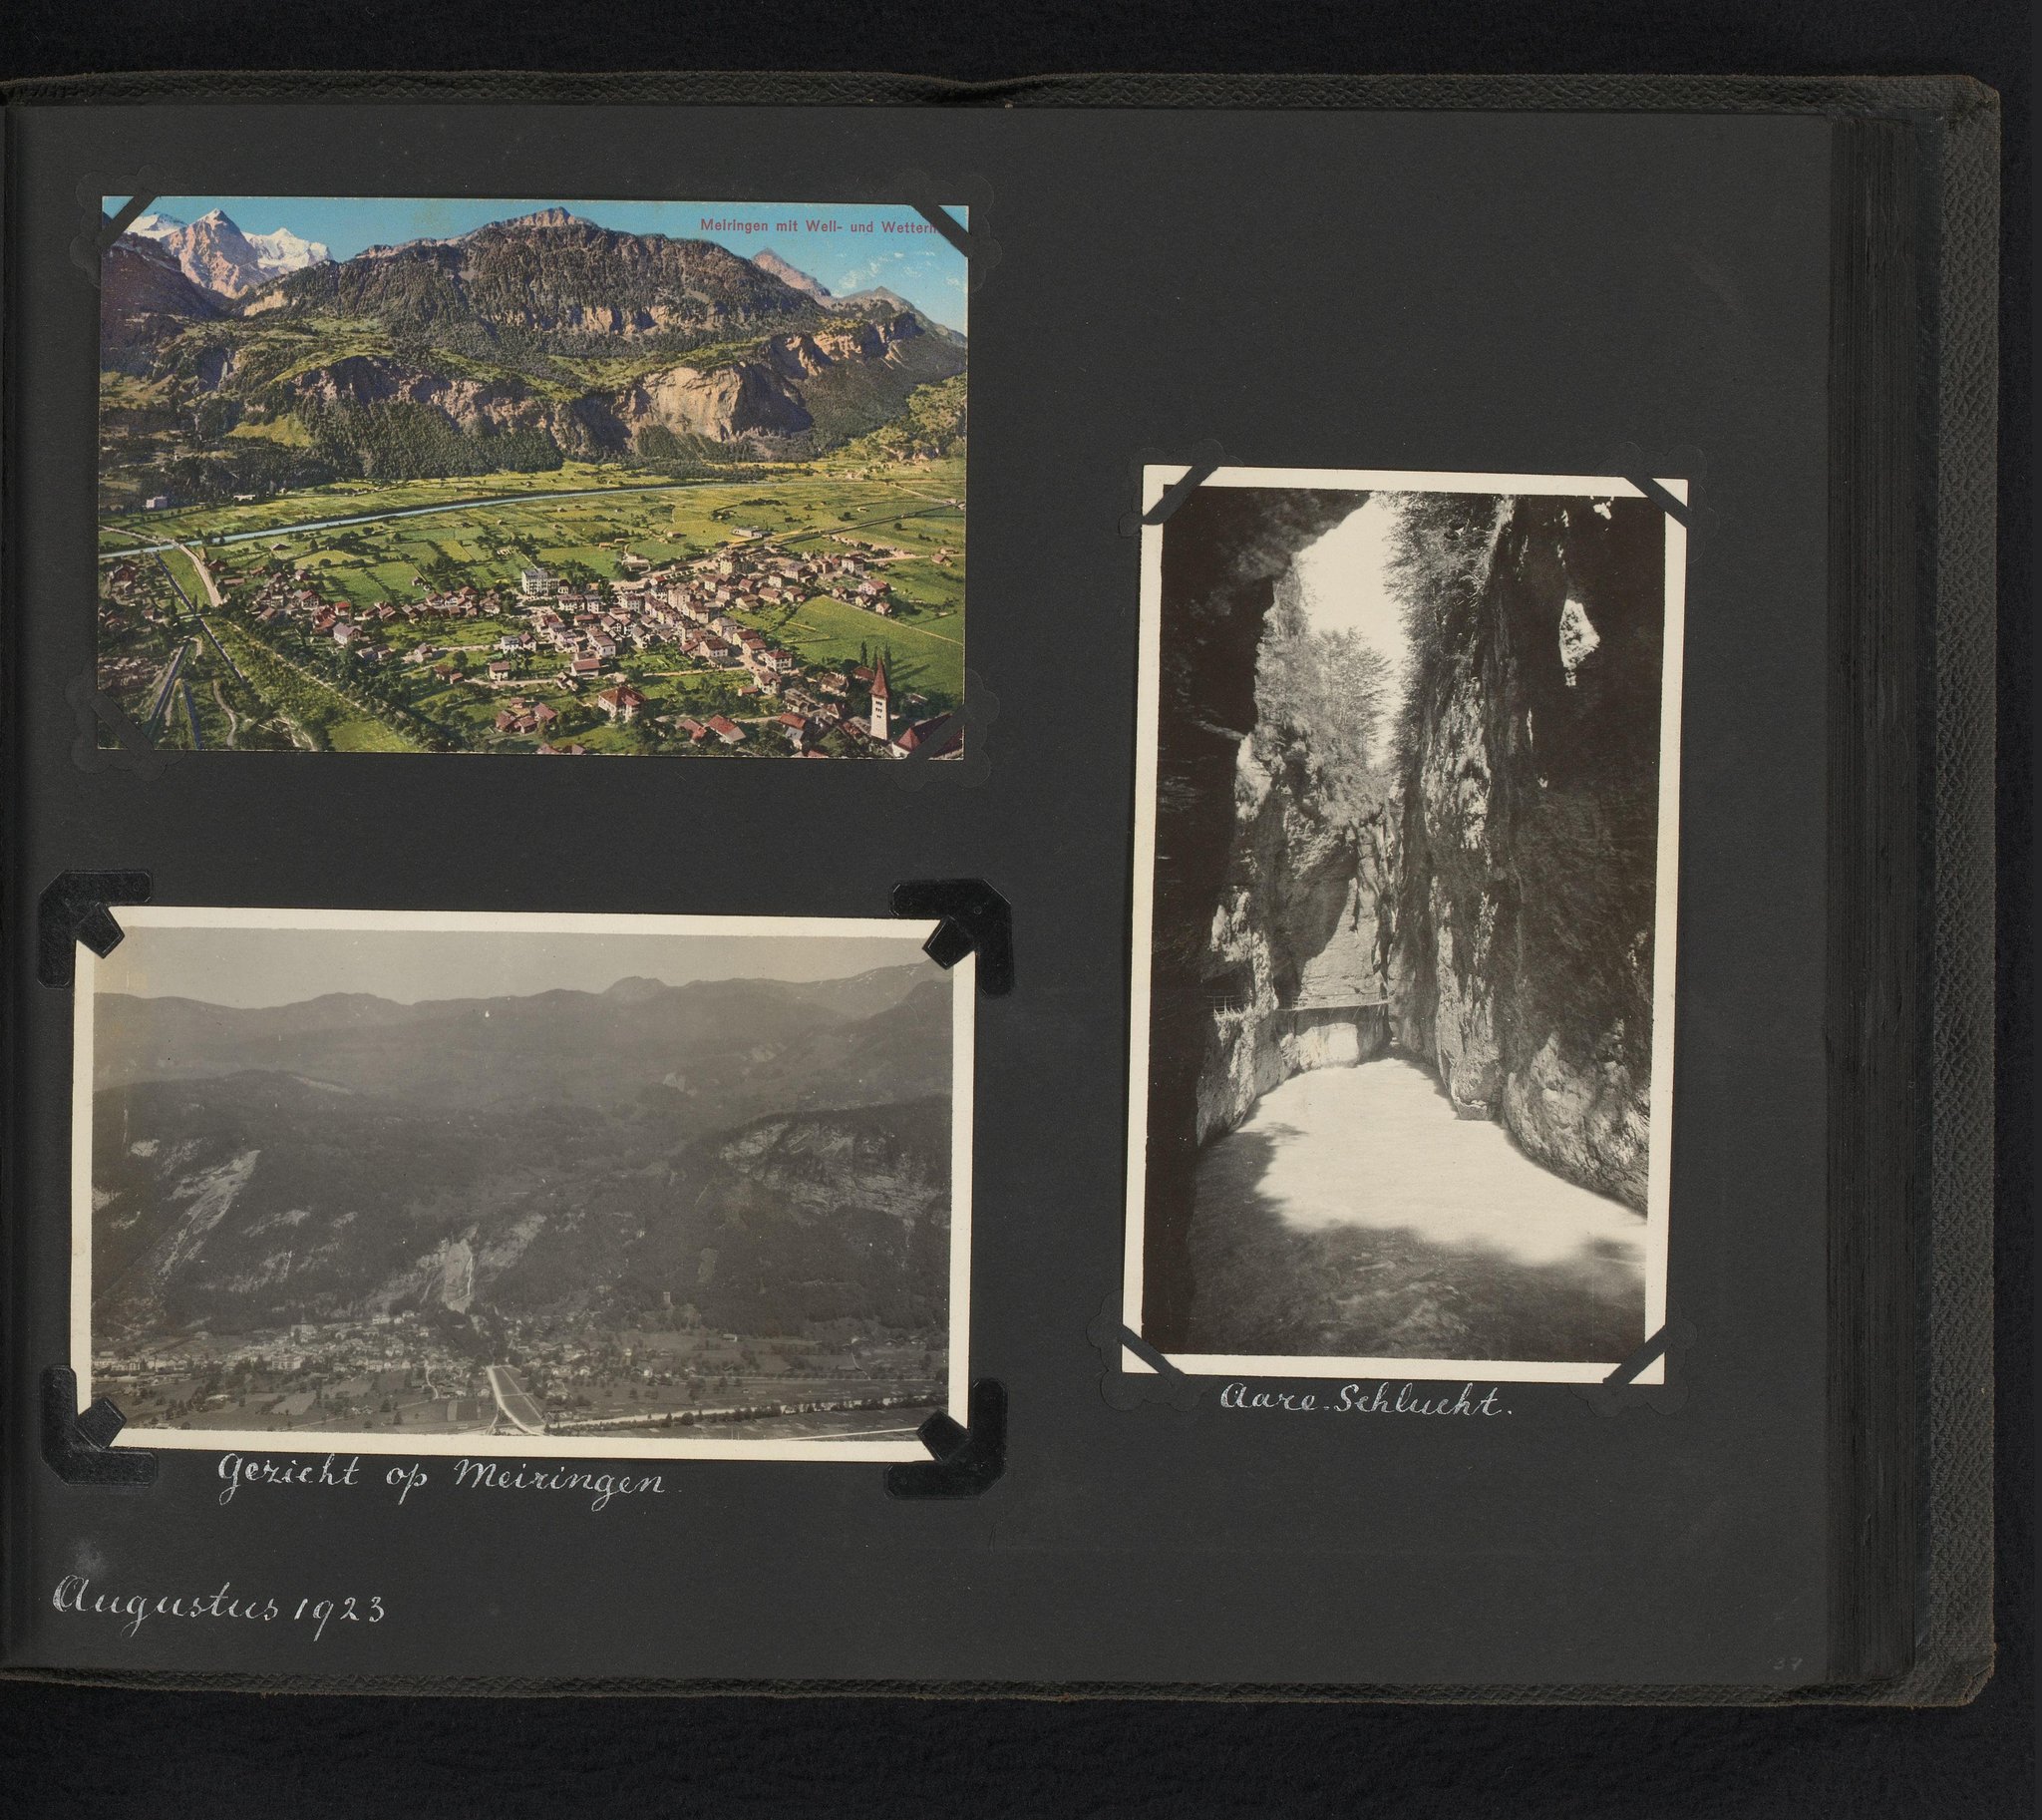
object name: album leaf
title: Twee foto's en een fotomechanische prentbriefkaart van Meiringen en de Aareschlucht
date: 1908-1923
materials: paper, cardboard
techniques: gelatin silver print, photolithography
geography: bern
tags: ravine, chasm, abyss, canyon, village, mountains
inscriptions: inscription: ‘Gezicht op Meiringen’, inscription: ‘Aare Schlucht’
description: Deze foto's en prent maken deel uit van een album.